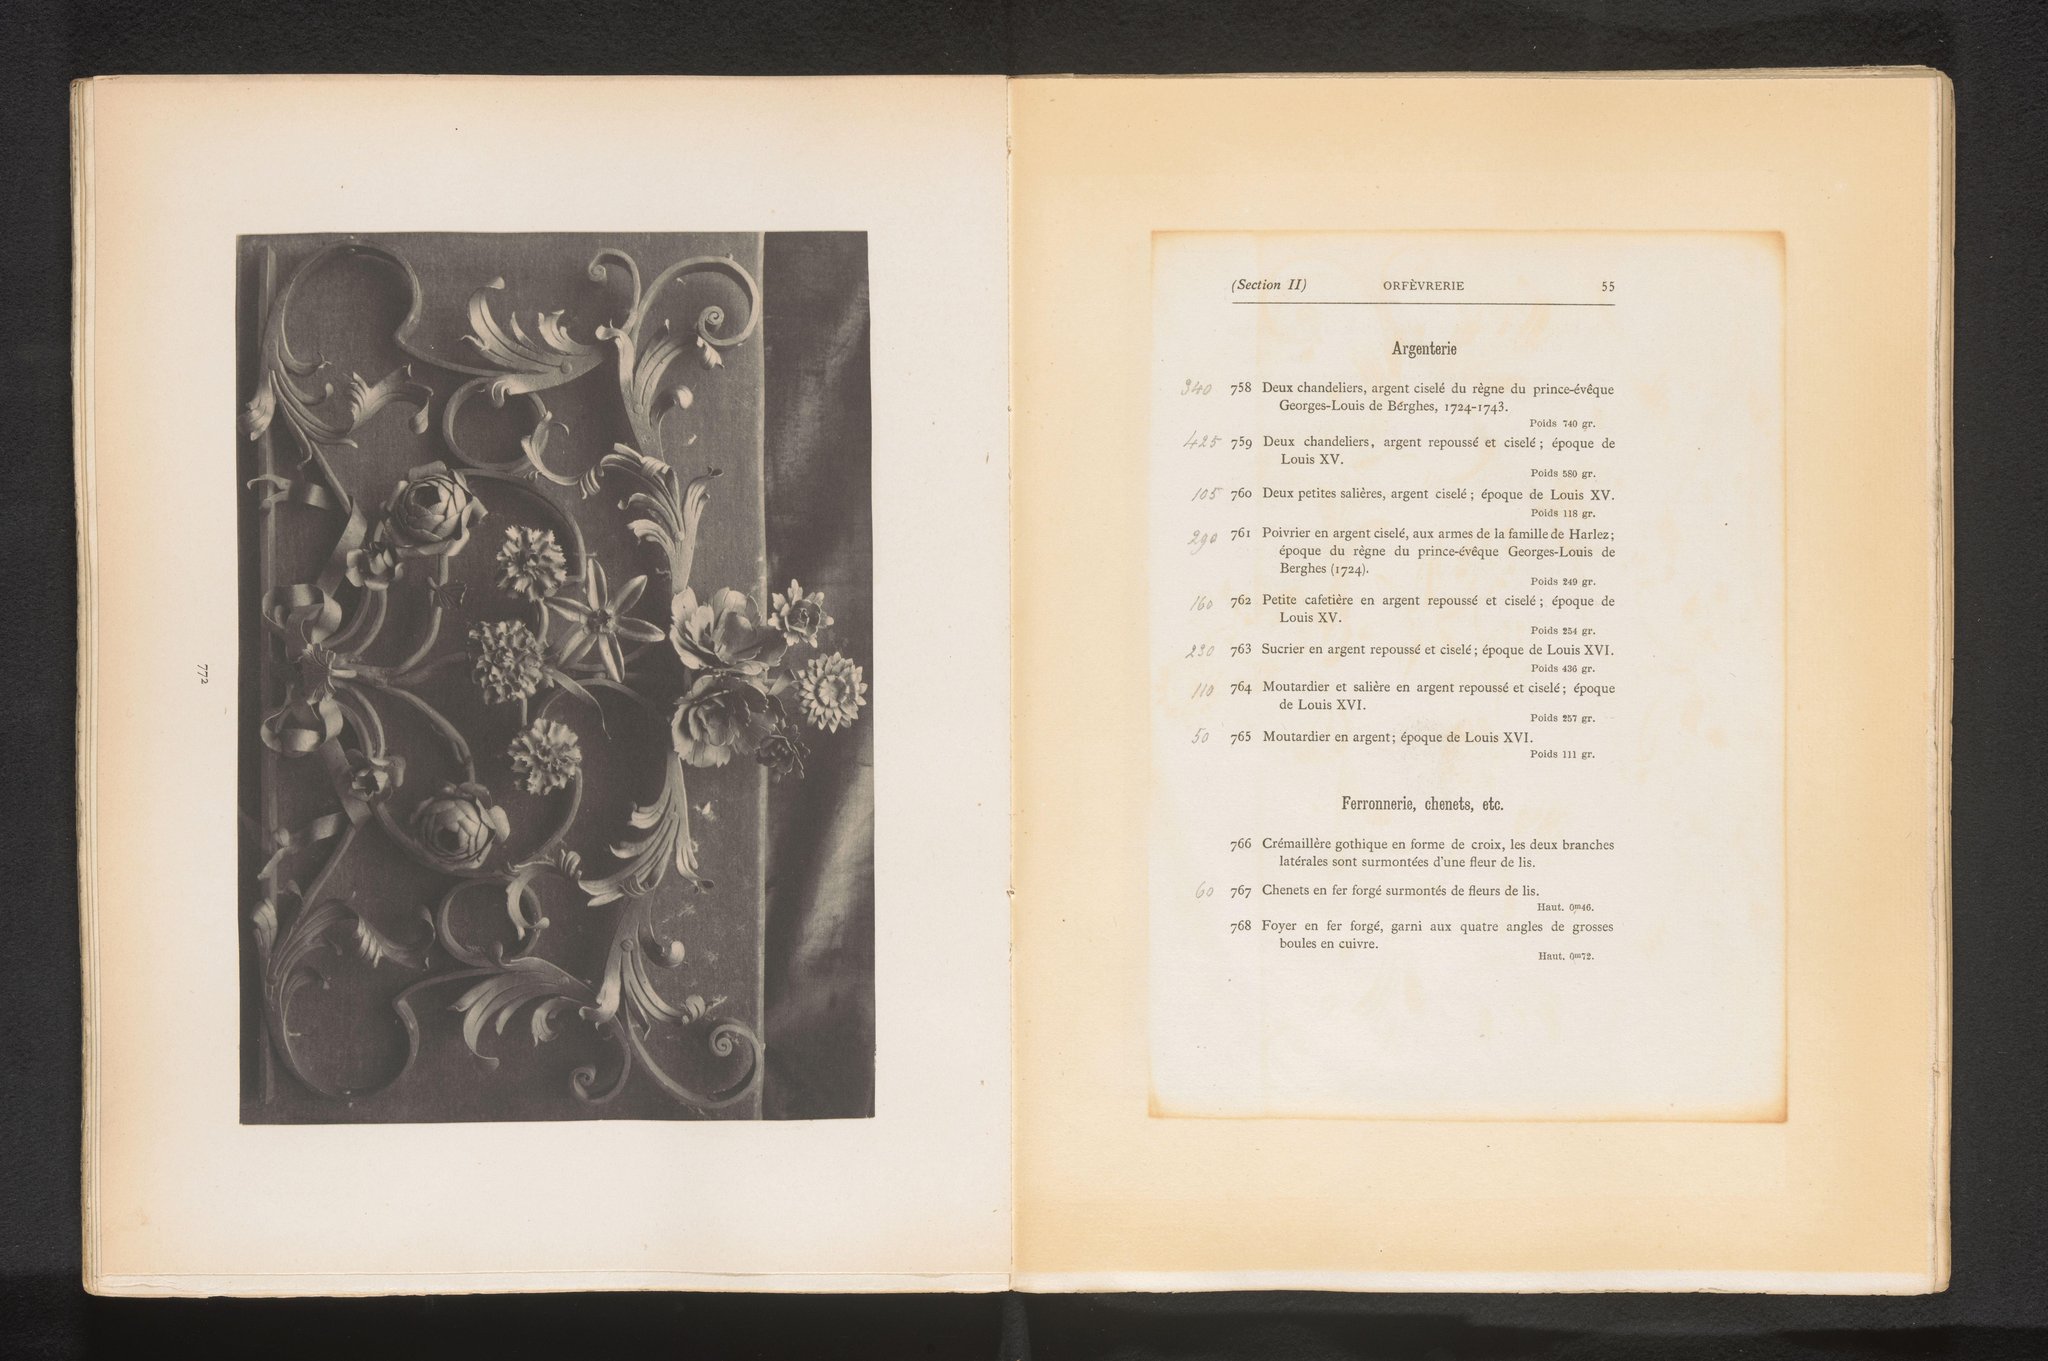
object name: page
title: Smeedijzeren werk met bloemen uit de collectie van Antonin Terme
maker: Anonymous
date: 1880-1885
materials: photographic support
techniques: platinum process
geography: liège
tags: art collection, art gallery